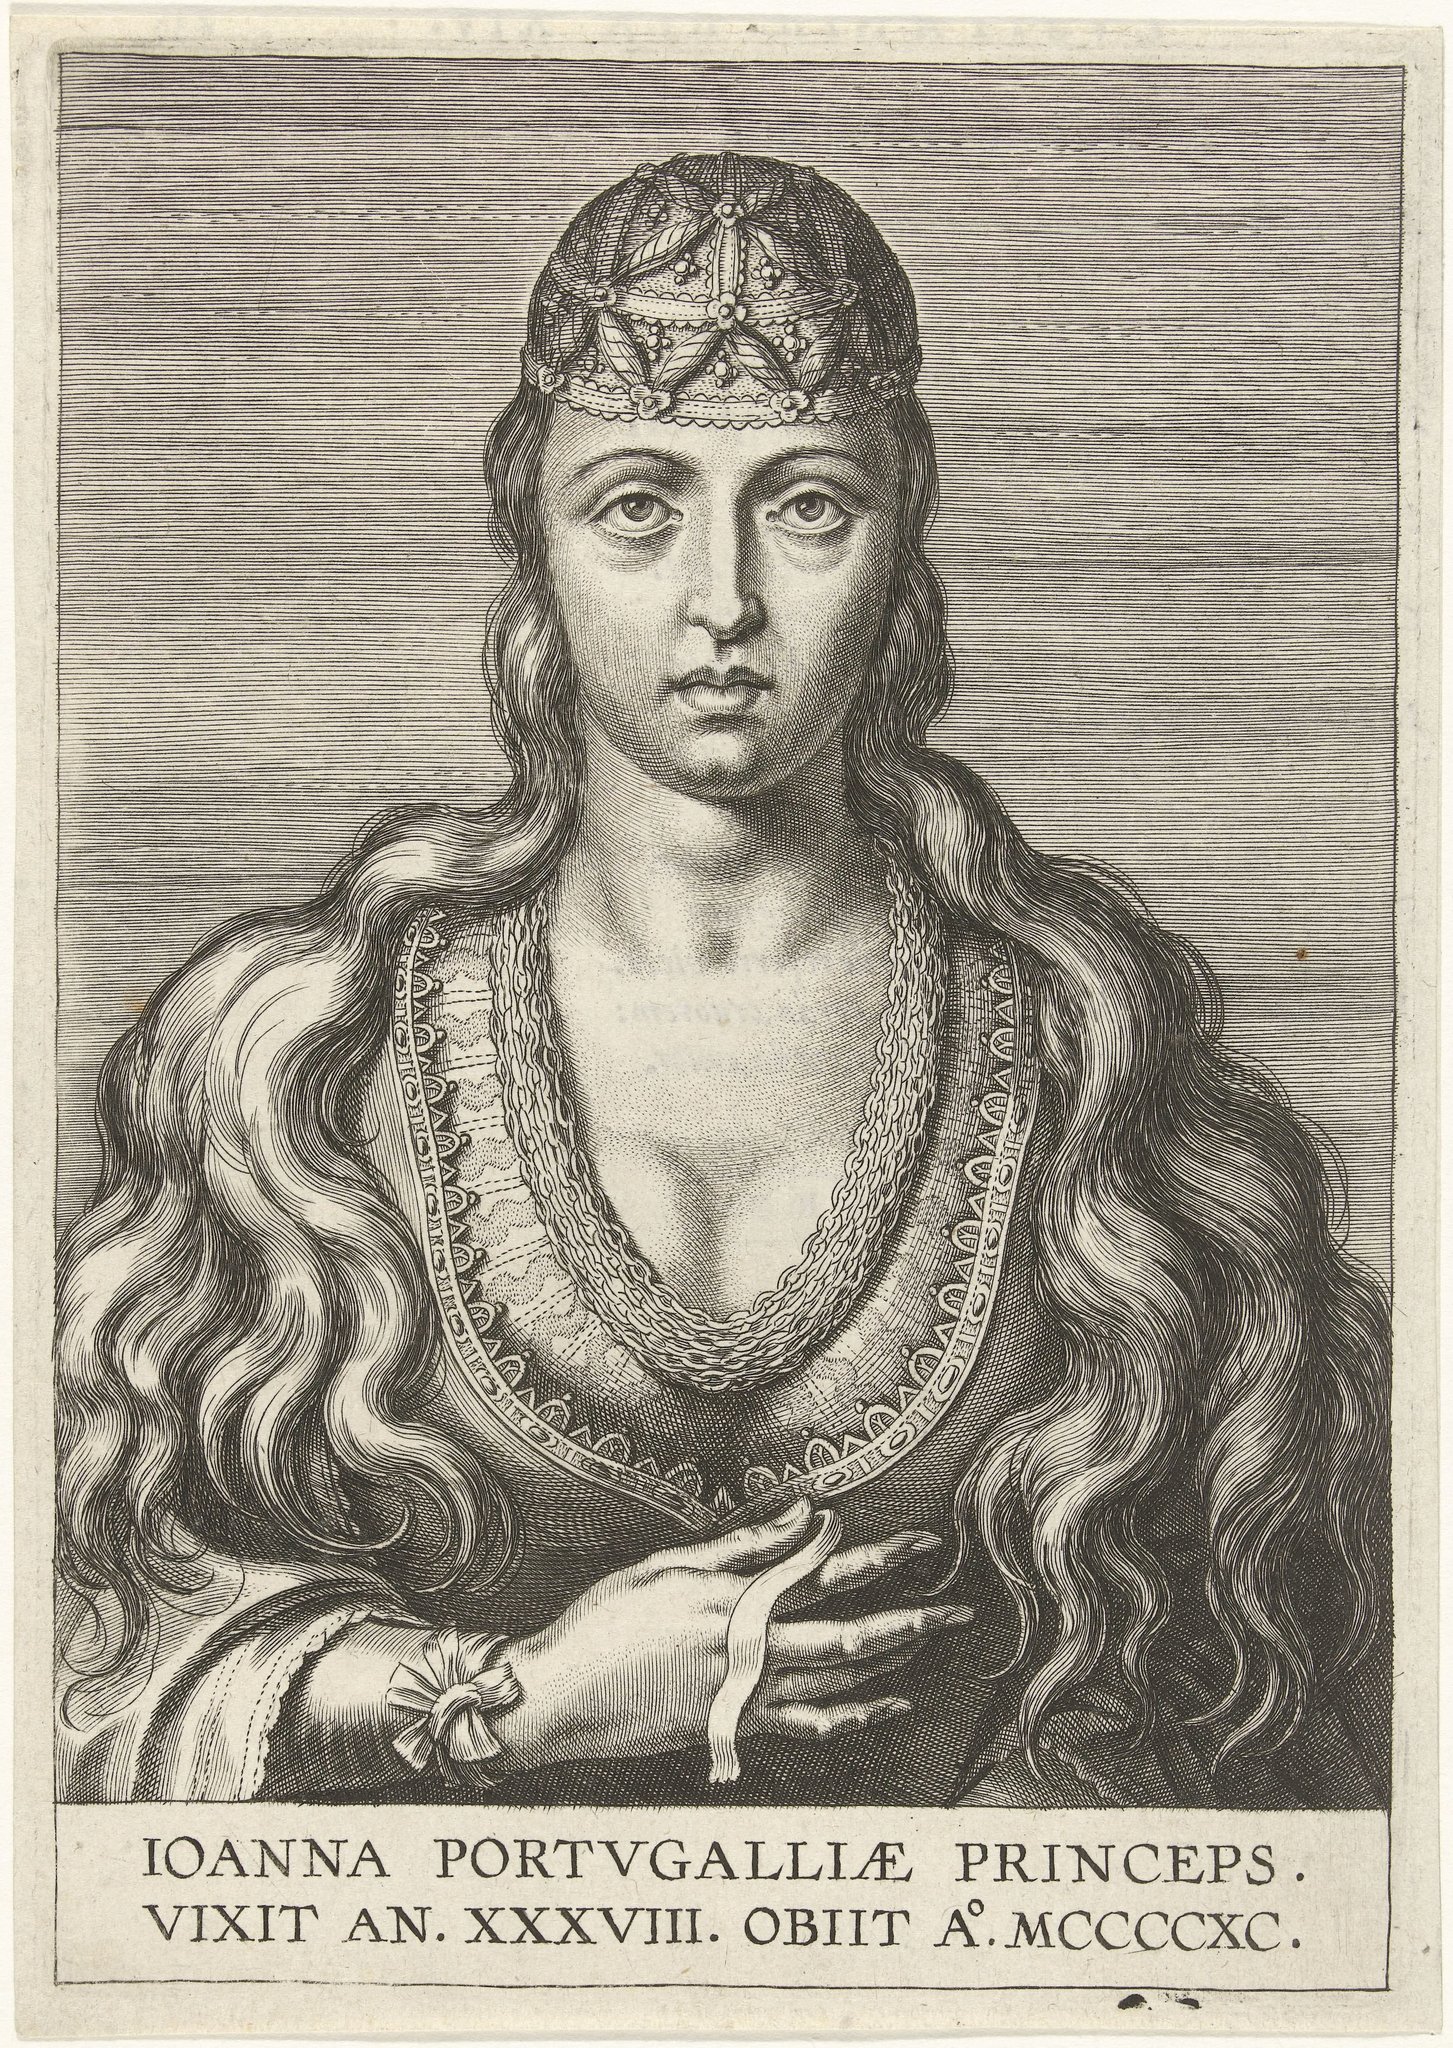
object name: book illustration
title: Portret van prinses Joanna van Portugal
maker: cornelis galle (i)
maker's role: print maker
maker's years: 1576-1650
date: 1621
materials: paper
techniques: engraving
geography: southern netherlands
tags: joanna (prinses van portugal), portugal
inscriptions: collector's mark: Lugt 2228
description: Illustratie voor: Antonio Vasconcellos. Anacephalæoses id est, Svmma captia actorvm regvm Lvsitaniæ. Antwerpen: Petrus II en Joannes II Bellerus, 1621, of latere druk.